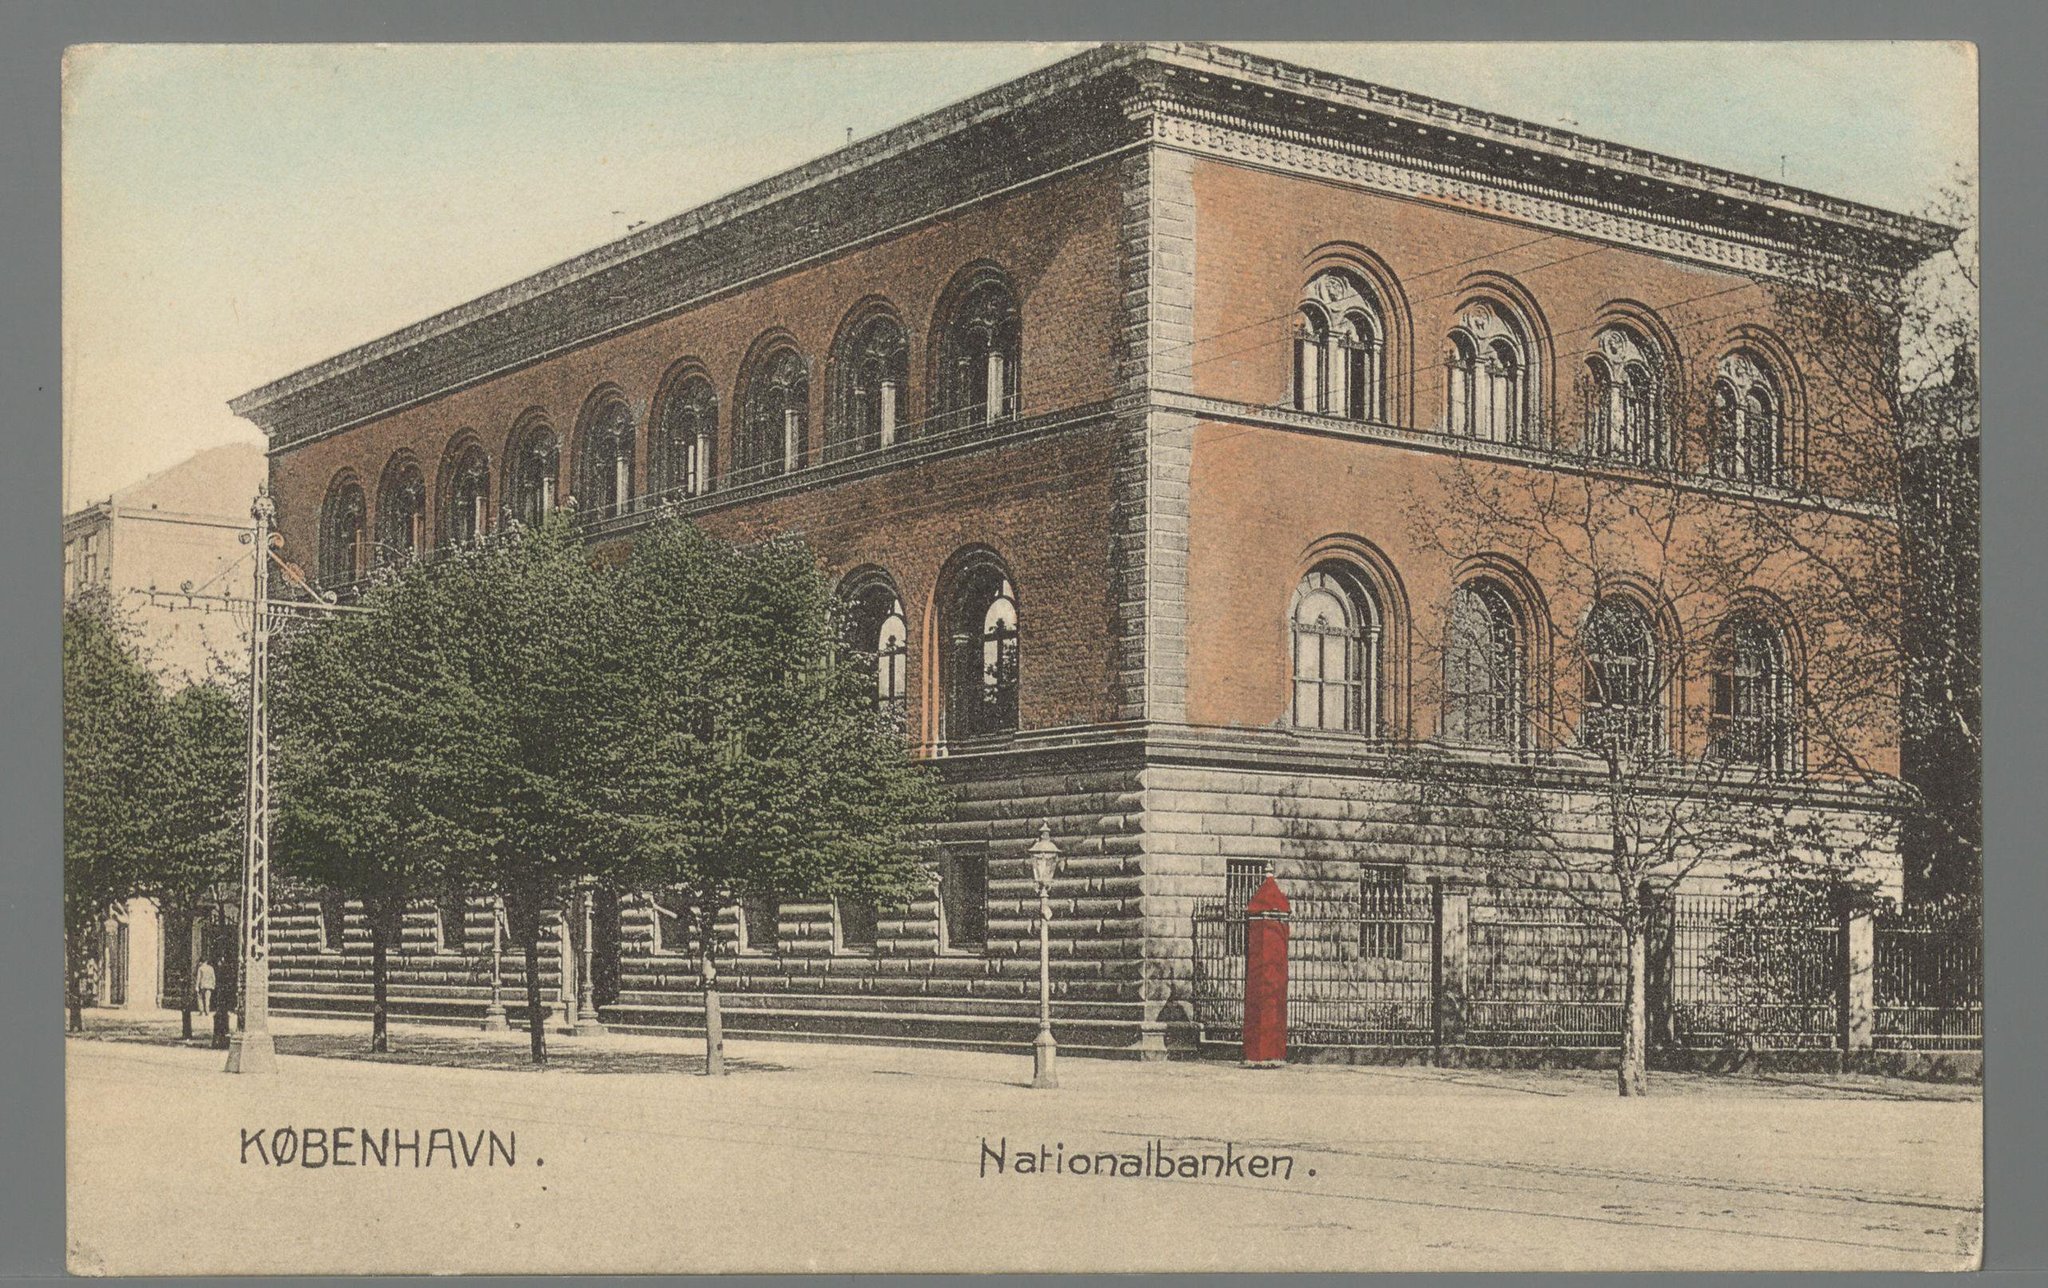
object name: ansichtkaart, prentbriefkaart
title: København. Nationalbanken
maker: Anonymous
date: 1906-1920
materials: cardboard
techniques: photograph, lithograph, hand coloring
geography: copenhagen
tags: city-view, and landscape with man-made constructions, bank, copenhagen (city)